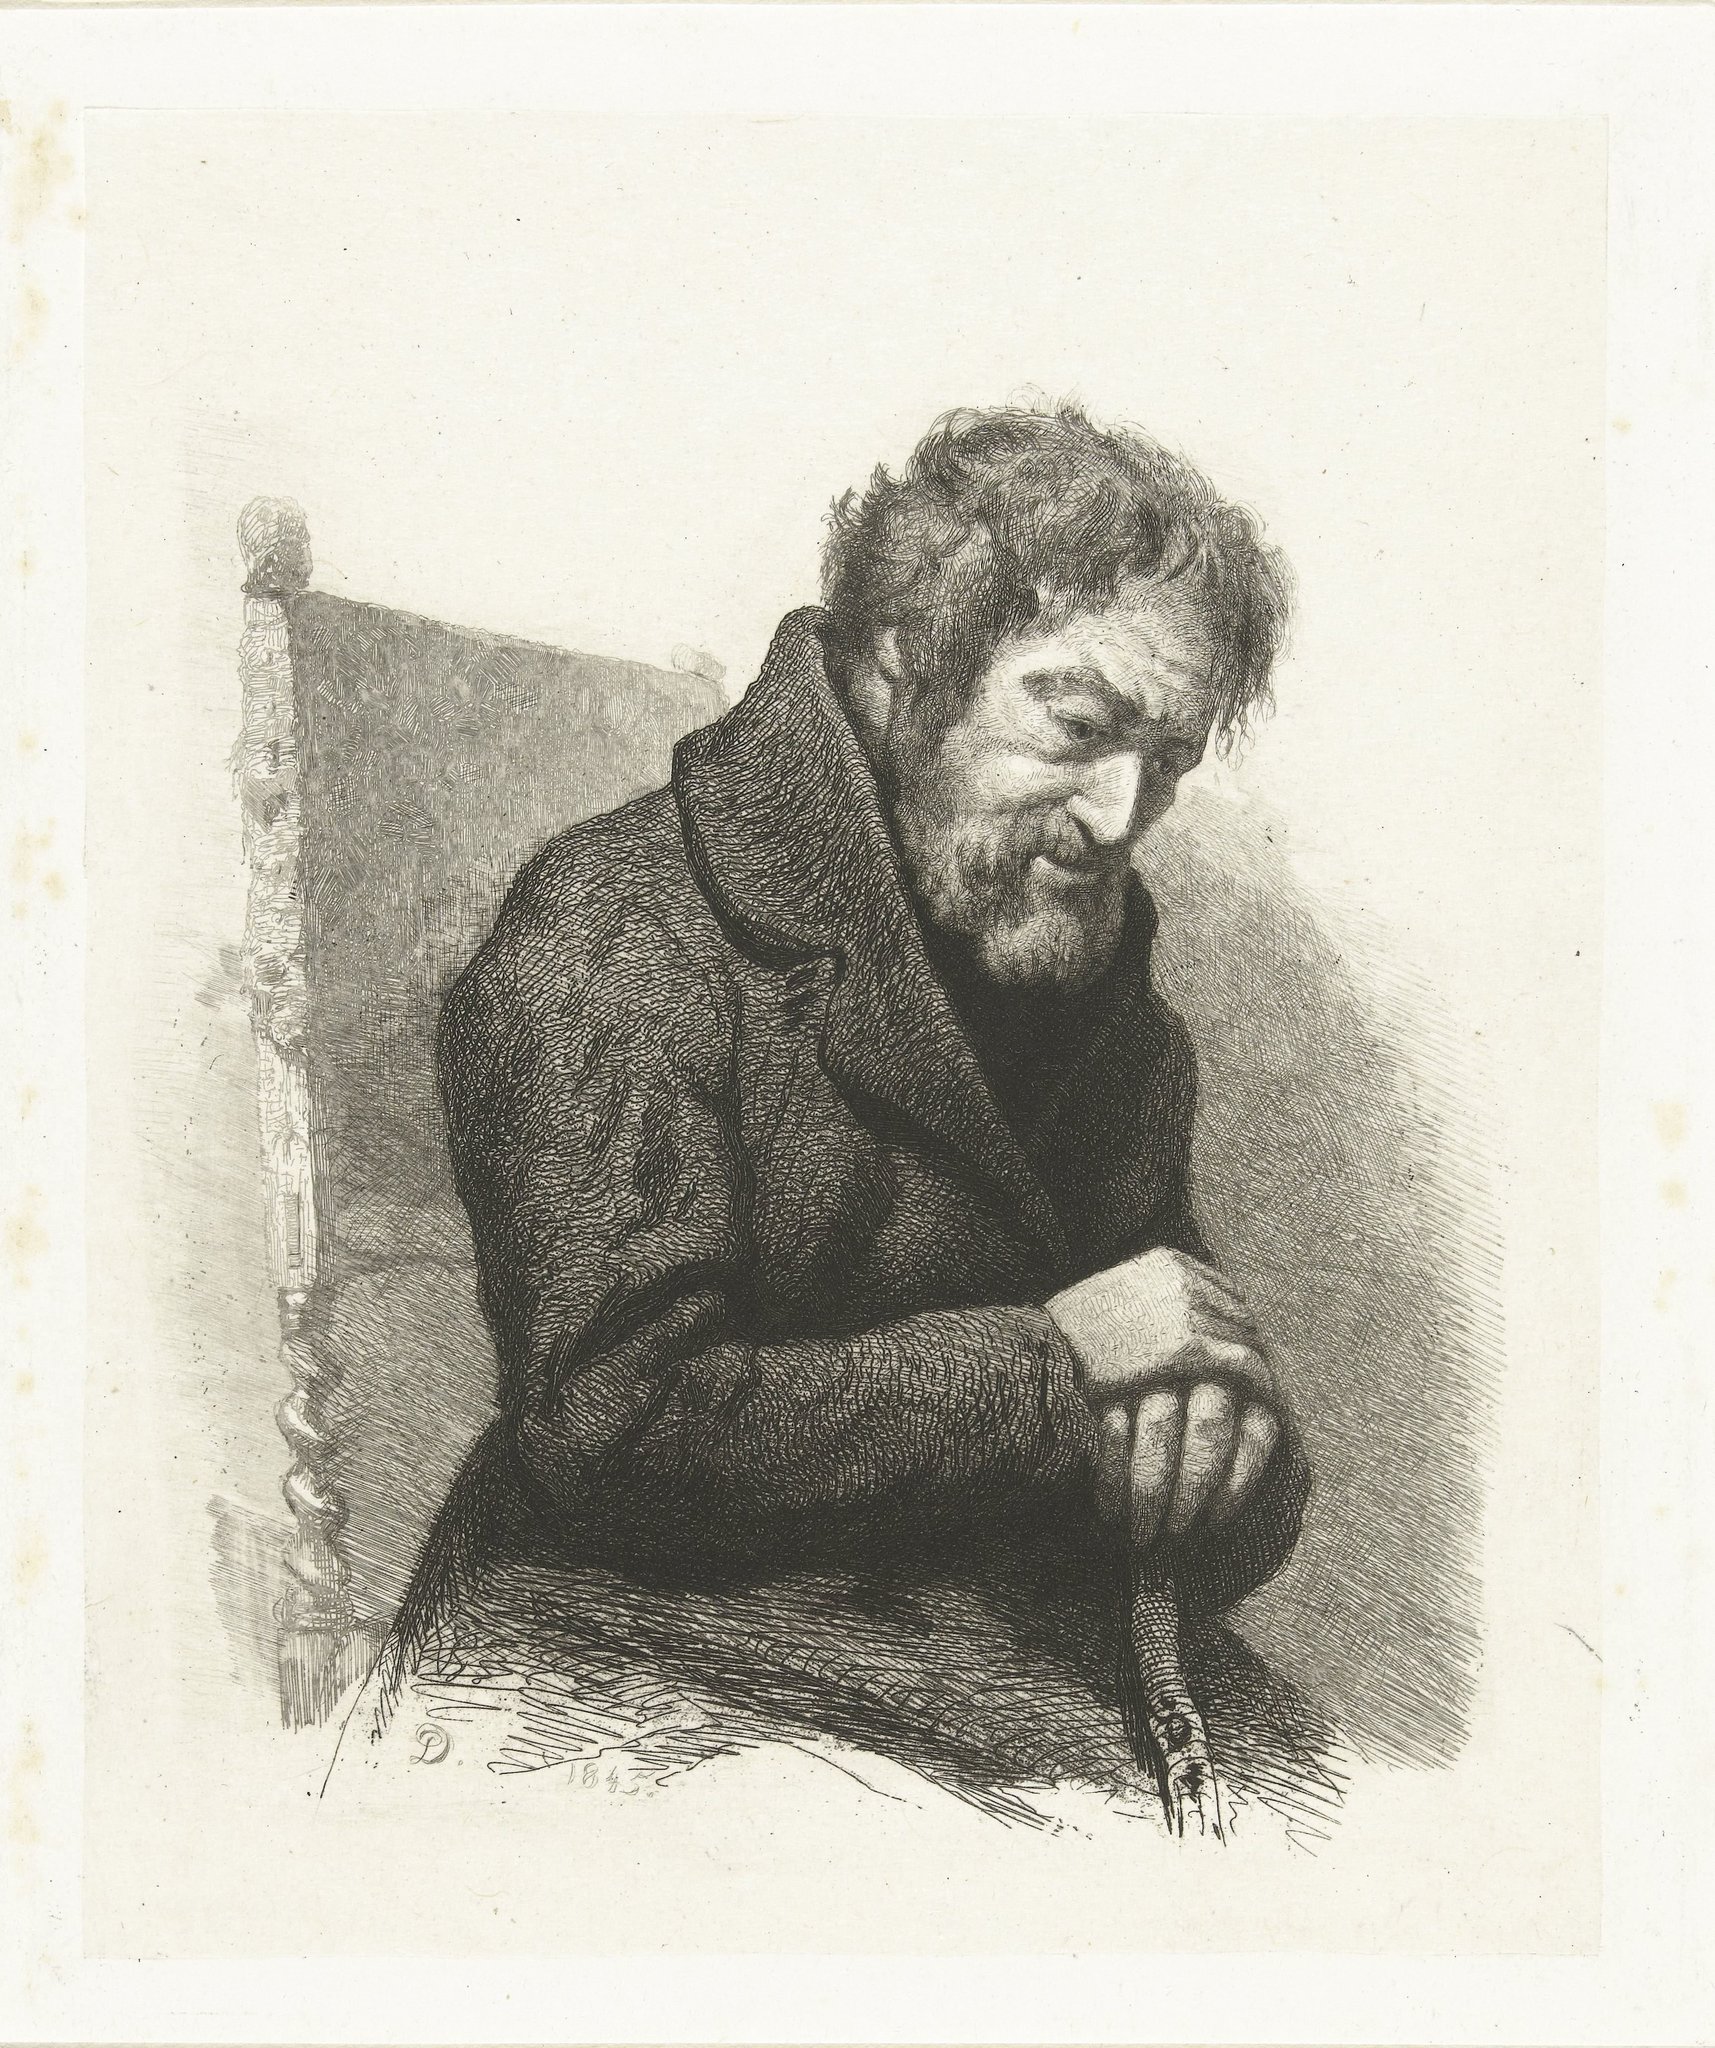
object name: print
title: Zittende grijsaard met wandelstok in zijn handen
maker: pierre louis dubourcq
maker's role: draughtsman, painter, print maker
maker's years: 1815-1873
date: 1845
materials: paper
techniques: aquatint, etching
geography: netherlands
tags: old man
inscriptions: collector's mark: Lugt 2228